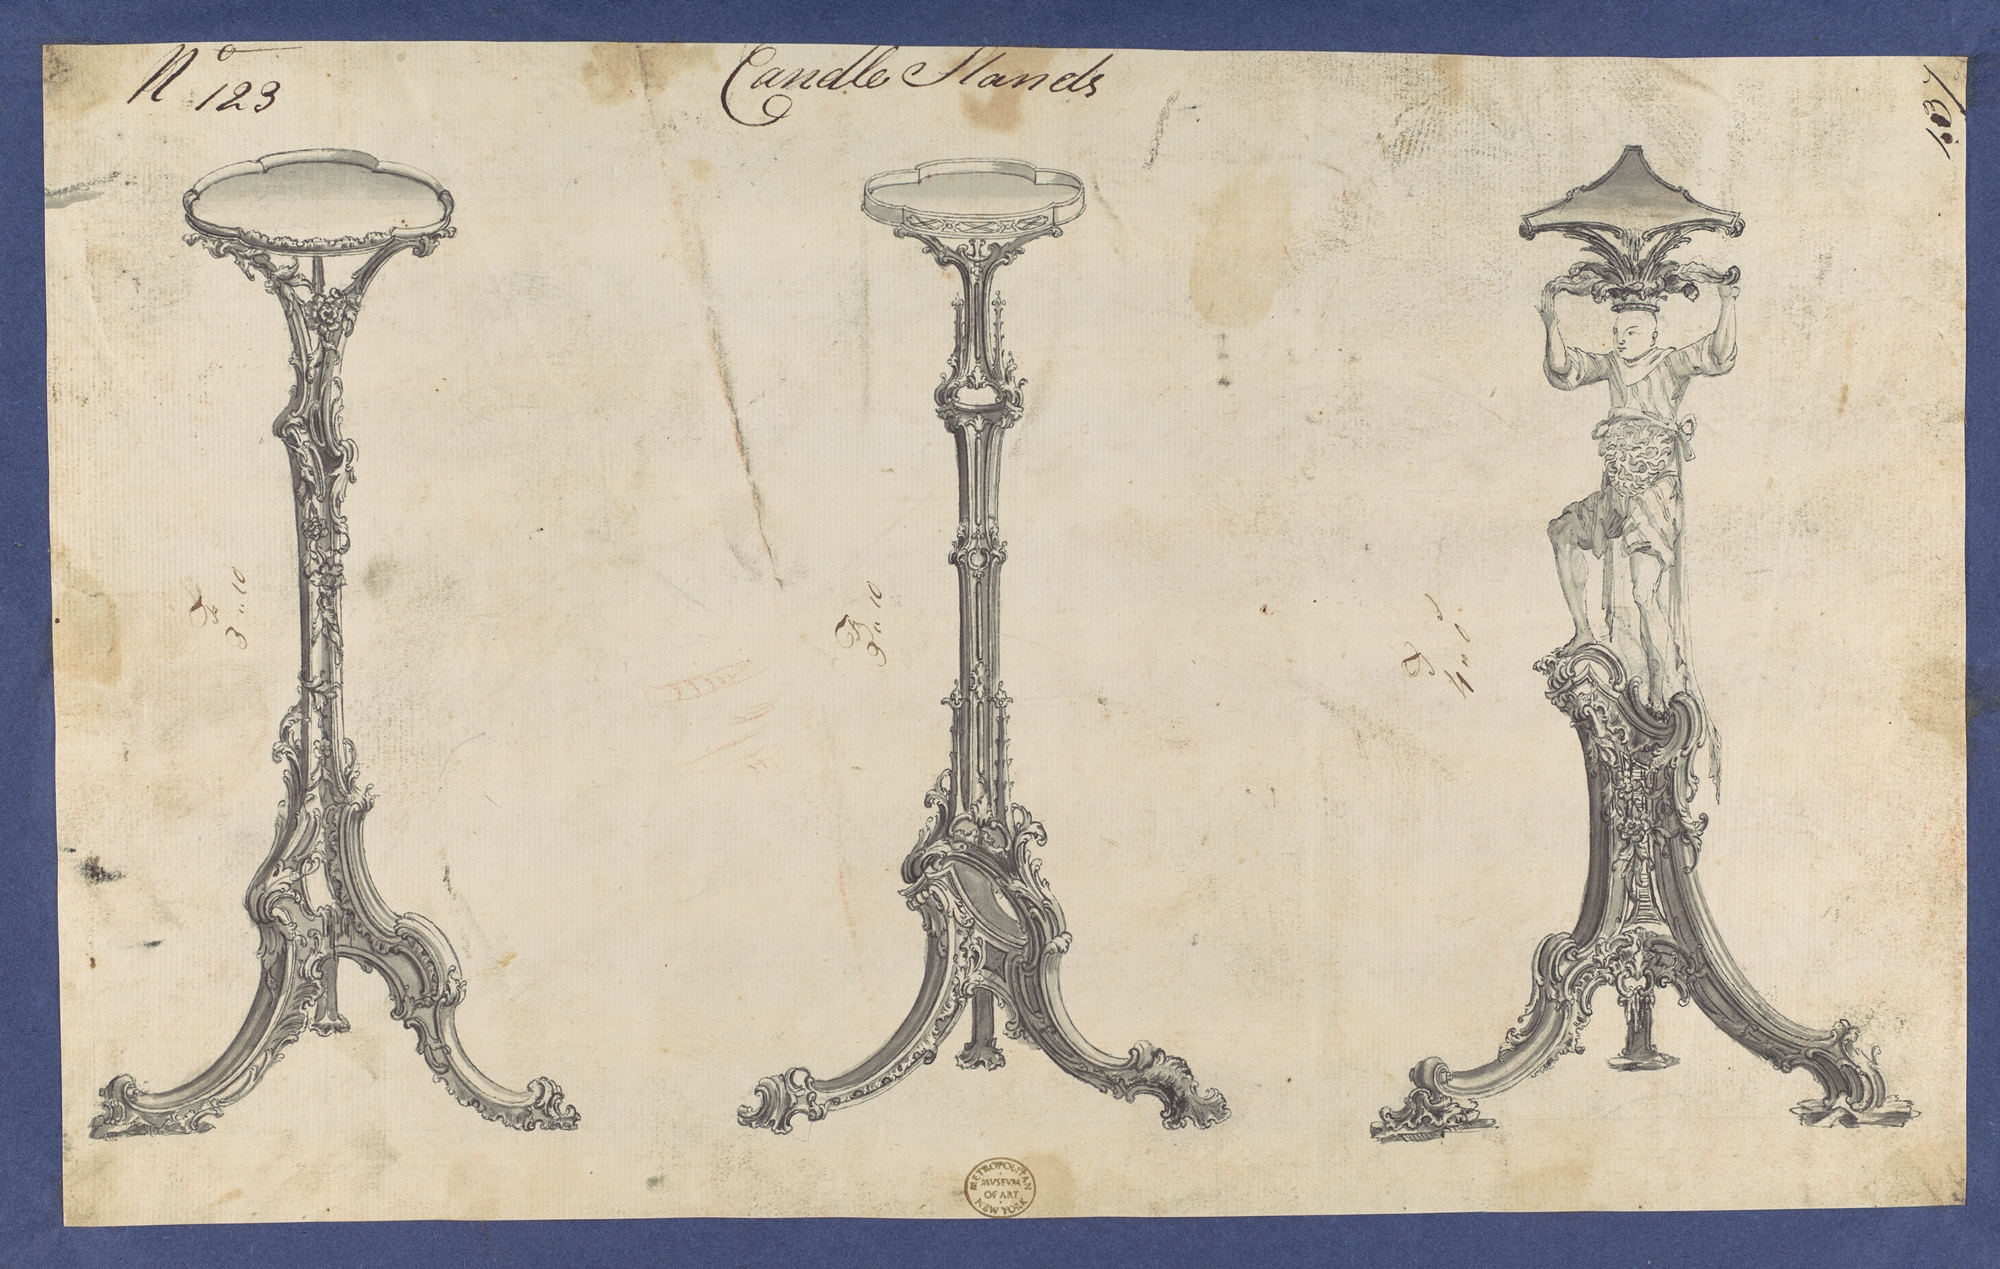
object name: drawing ornament architecture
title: Candle Stands, in Chippendale Drawings, Vol. I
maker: thomas chippendale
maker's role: artist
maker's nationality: british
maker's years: 1718-1779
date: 1753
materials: ink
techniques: wash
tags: furniture